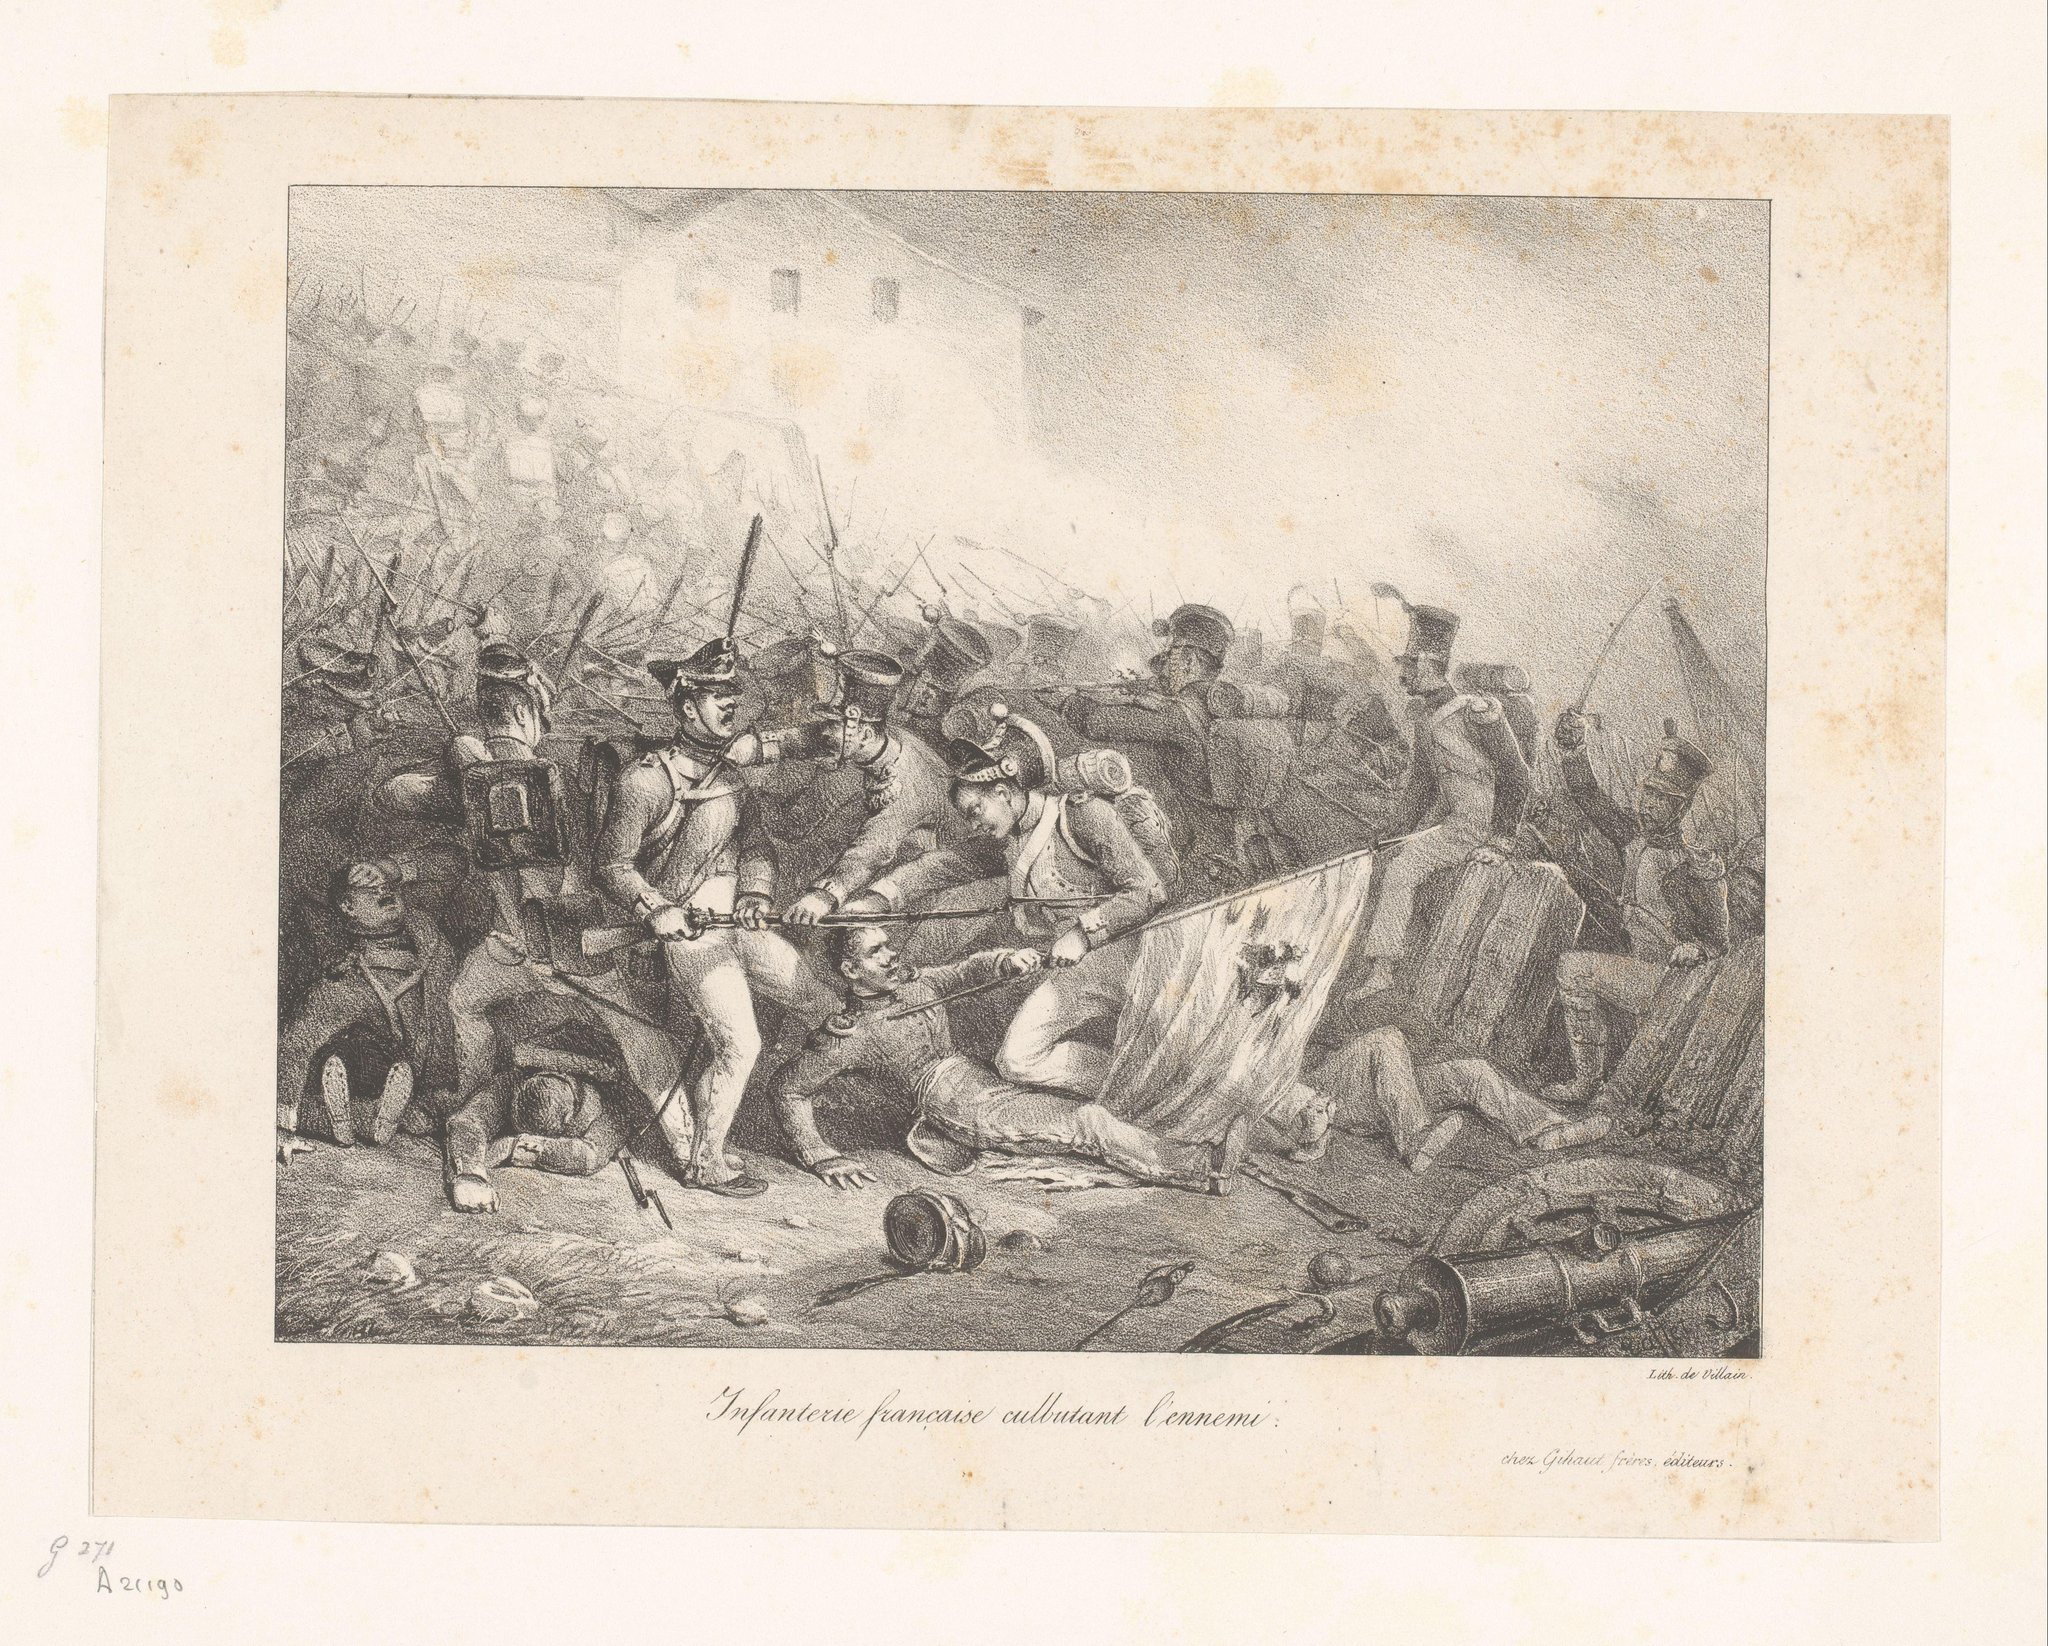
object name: print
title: Franse soldaten in gevecht met de vijand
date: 1828-1829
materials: paper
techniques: lithograph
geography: paris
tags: battle, firearms: rifle, the soldier; the soldier's life, flag, colours (as symbol of the state, etc.)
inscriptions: collector's mark: Lugt 964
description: Prent mogelijk verschenen in een onbekende serie uitgegeven door Gihaut frères.